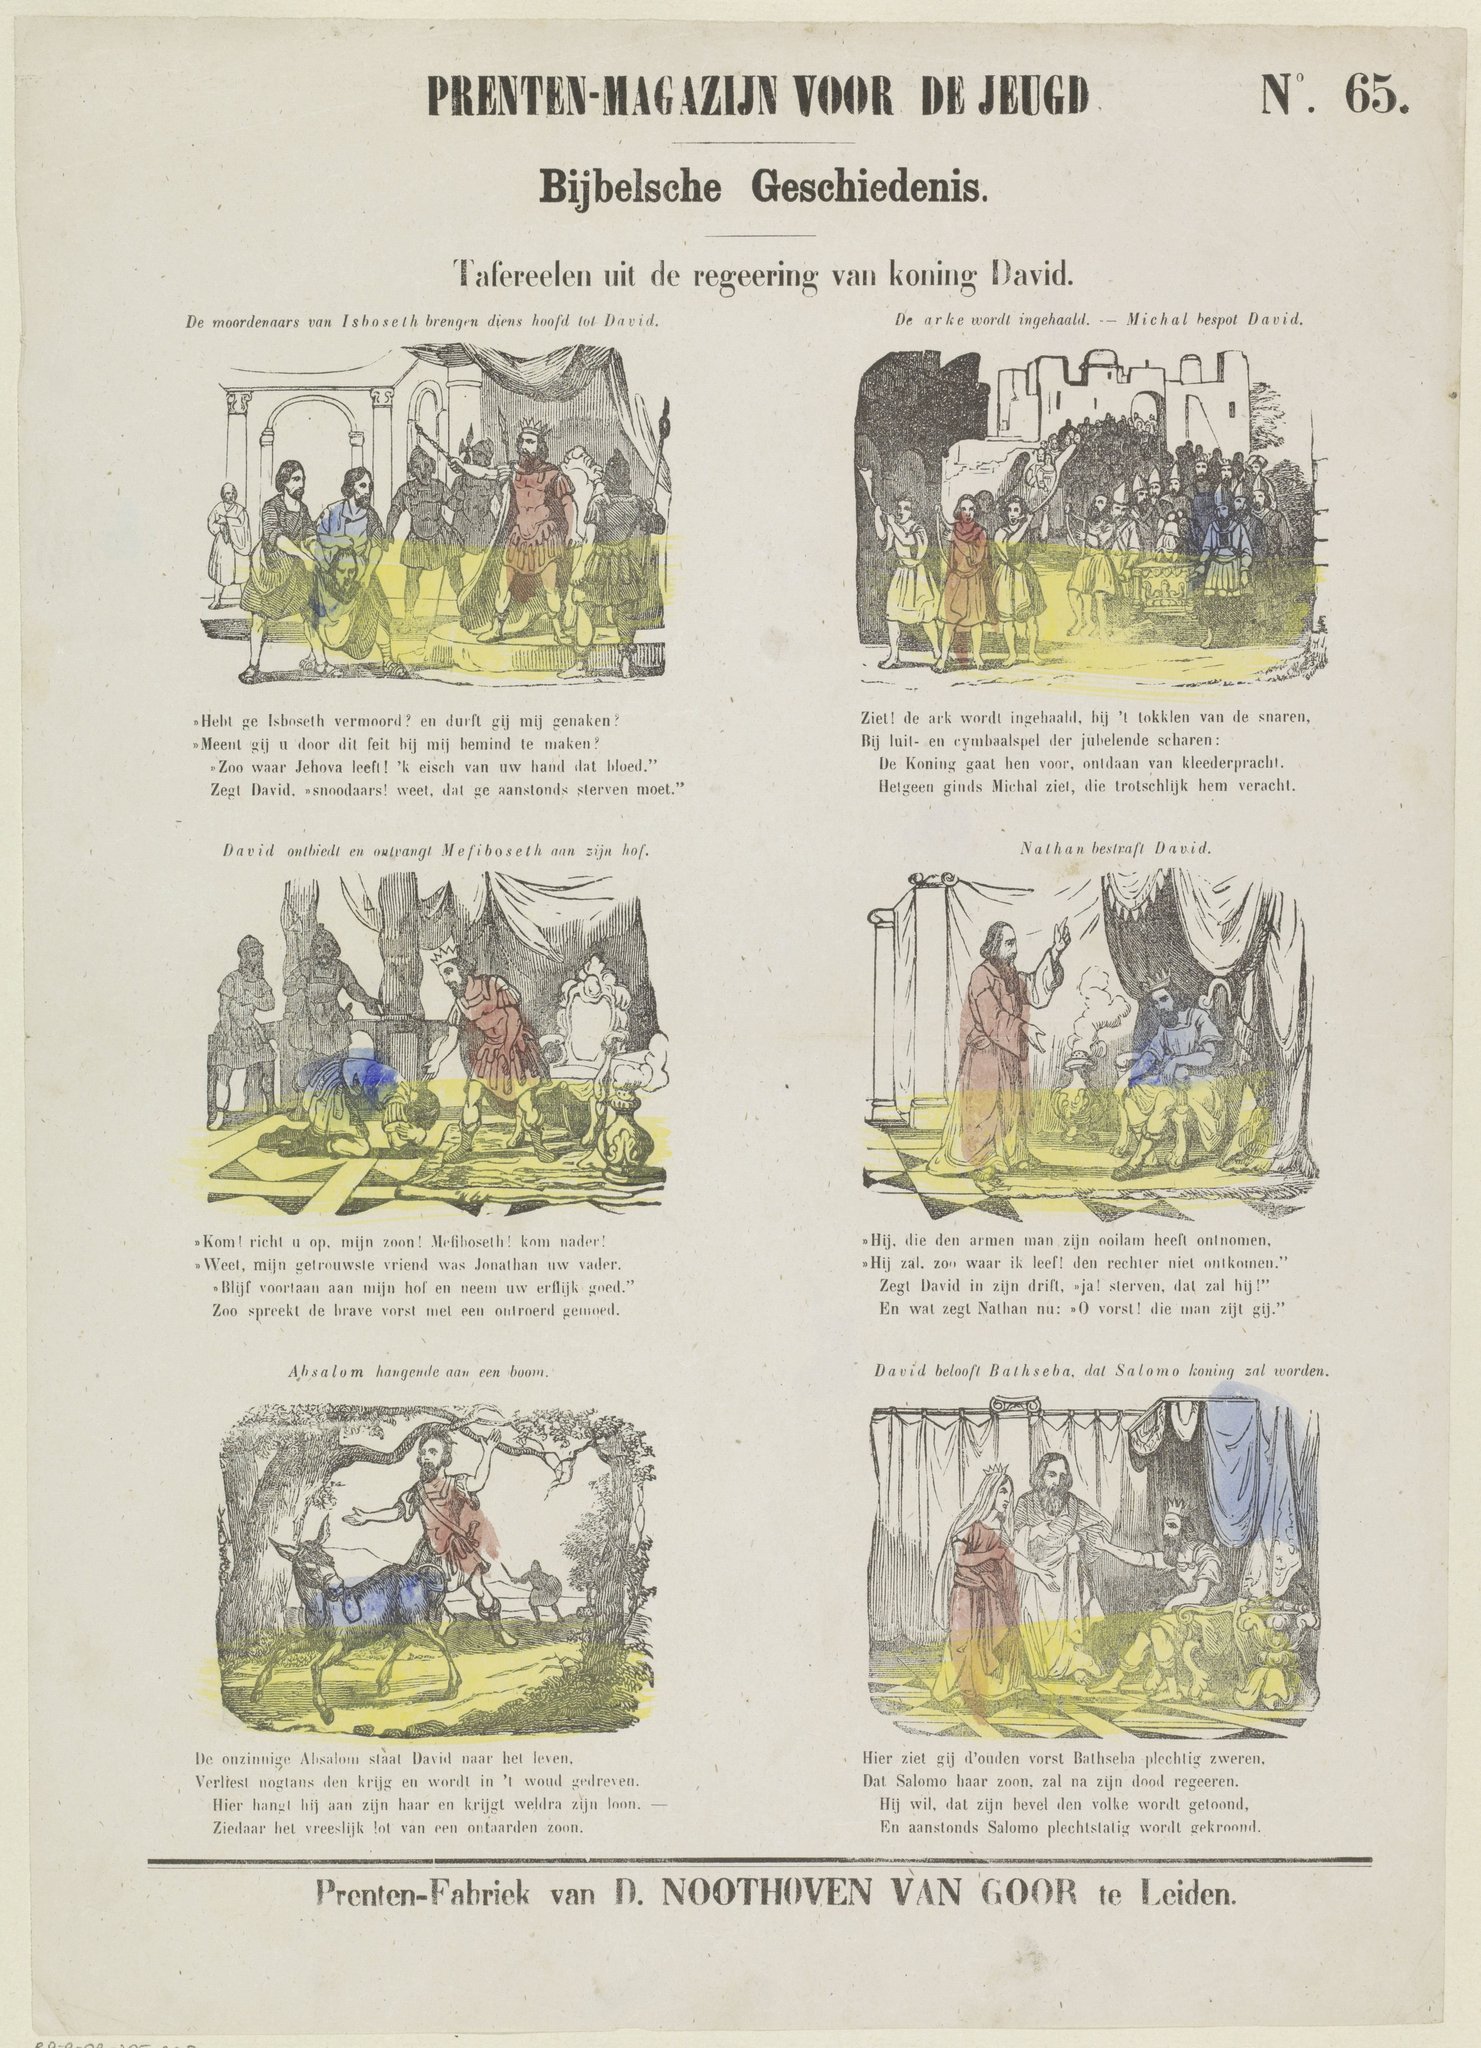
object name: print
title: Tafereelen uit de regering van koning David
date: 1850-1881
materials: paper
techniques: colour, letterpress printing, engraving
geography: netherlands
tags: story of david, old testament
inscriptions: collector's mark: Lugt 2760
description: Blad met 6 voorstellingen uit het leven van de oudtestamentische koning David. Boven elke voorstelling een titel en onder elke voorstelling een vierregelig vers. Genummerd rechtsboven: No. 65.